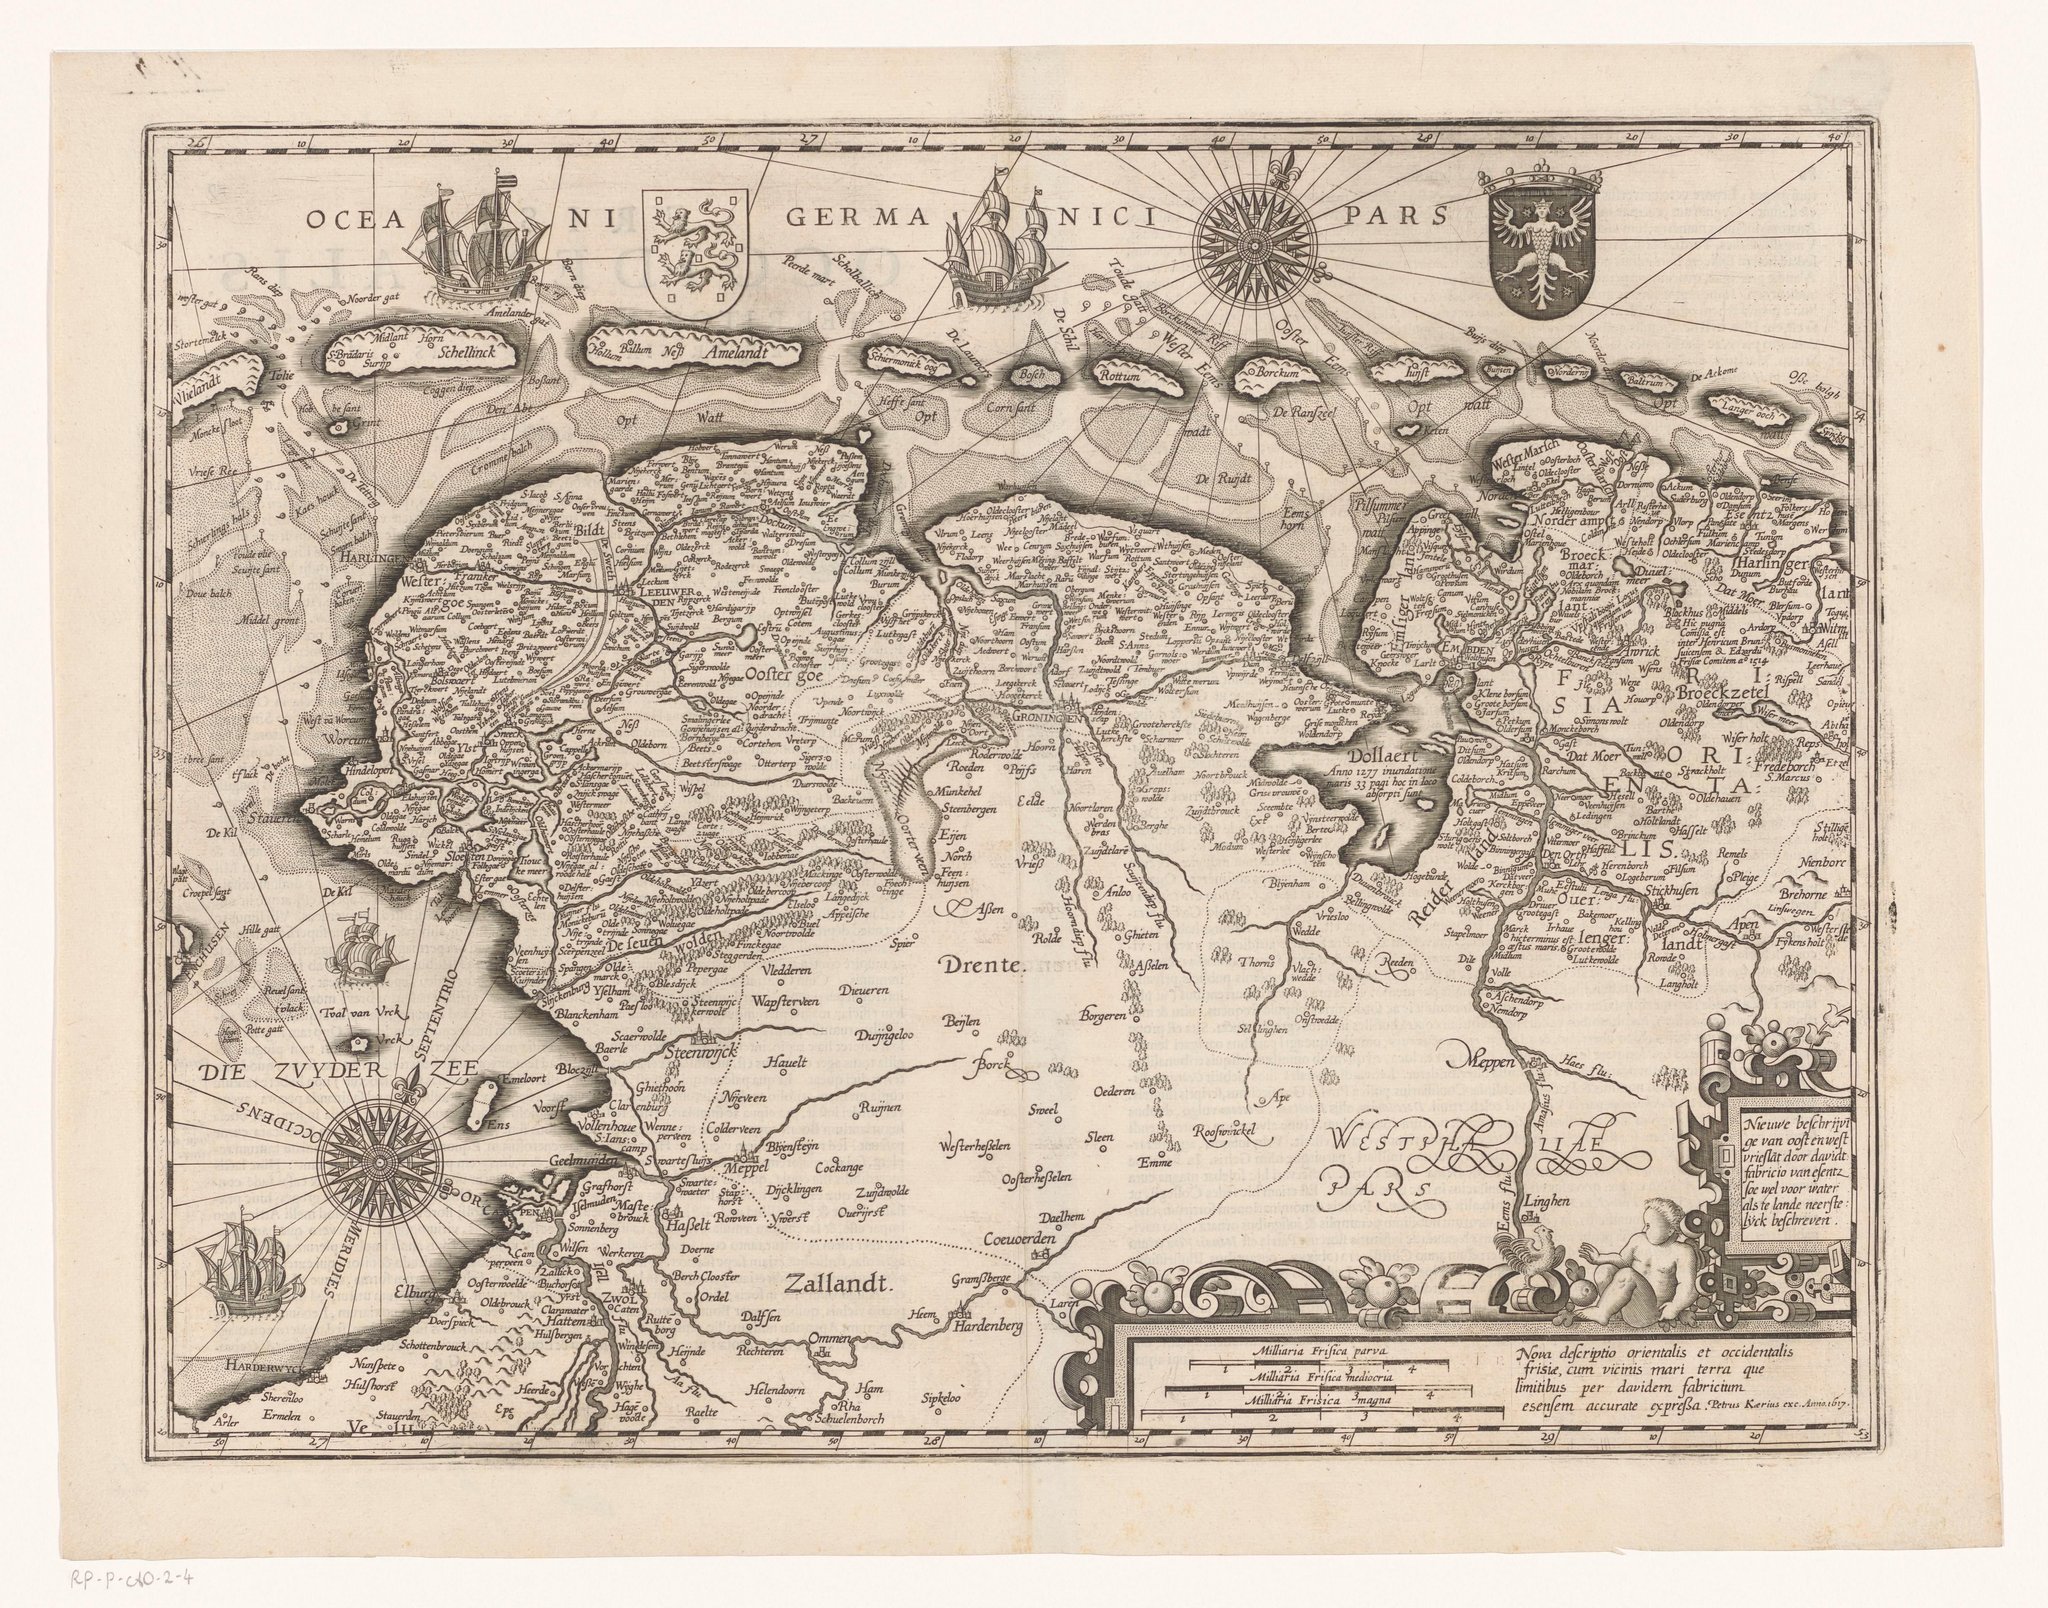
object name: print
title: Nieuwe beschrijvinge van oost en west vrieslat (...) / Nova descriptio orientalis et occidentalis frisiae (...)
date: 1617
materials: paper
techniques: engraving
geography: amsterdam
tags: coat of arms (as symbol of the state, etc.), maps of separate countries or regions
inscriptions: collector's mark: Lugt 2228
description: Bovenaan de wapens van Friesland en Oost-Friesland. Rechtsonder cartouche met titels en drie schaalstokken: Milliaria Frisica parua, Milliaria Frisica mediocria, Milliaria Frisica magna. Gradenverdeling langs de randen.